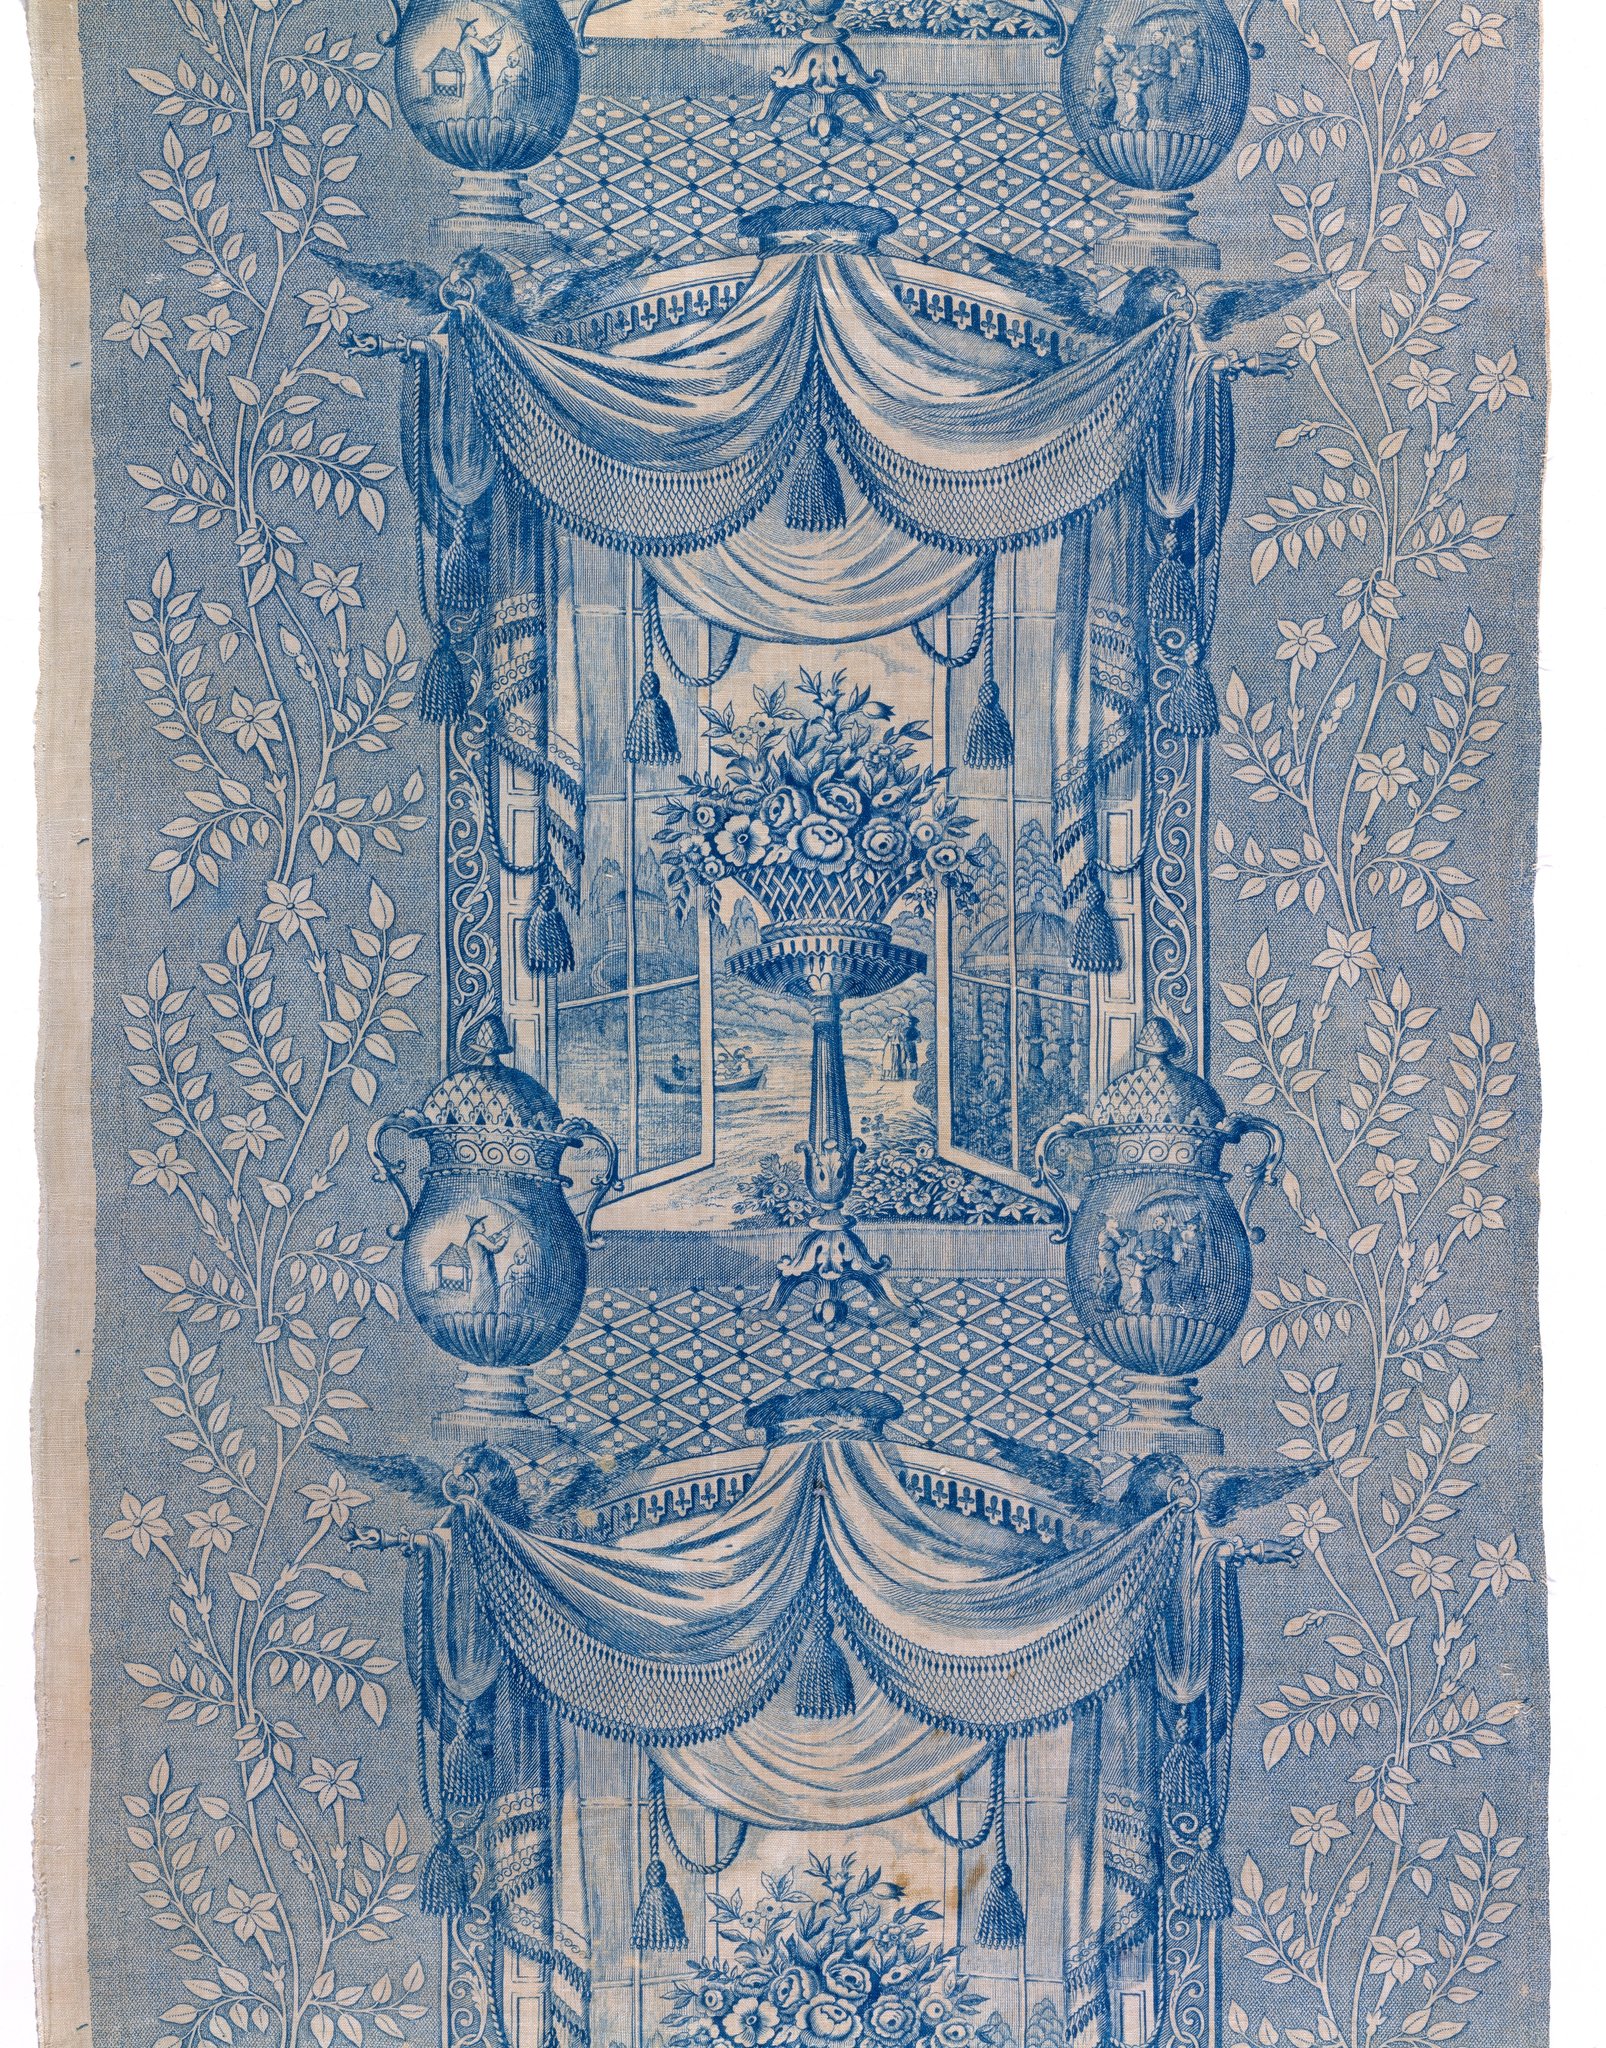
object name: piece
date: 1820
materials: cotton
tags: windows,flowers